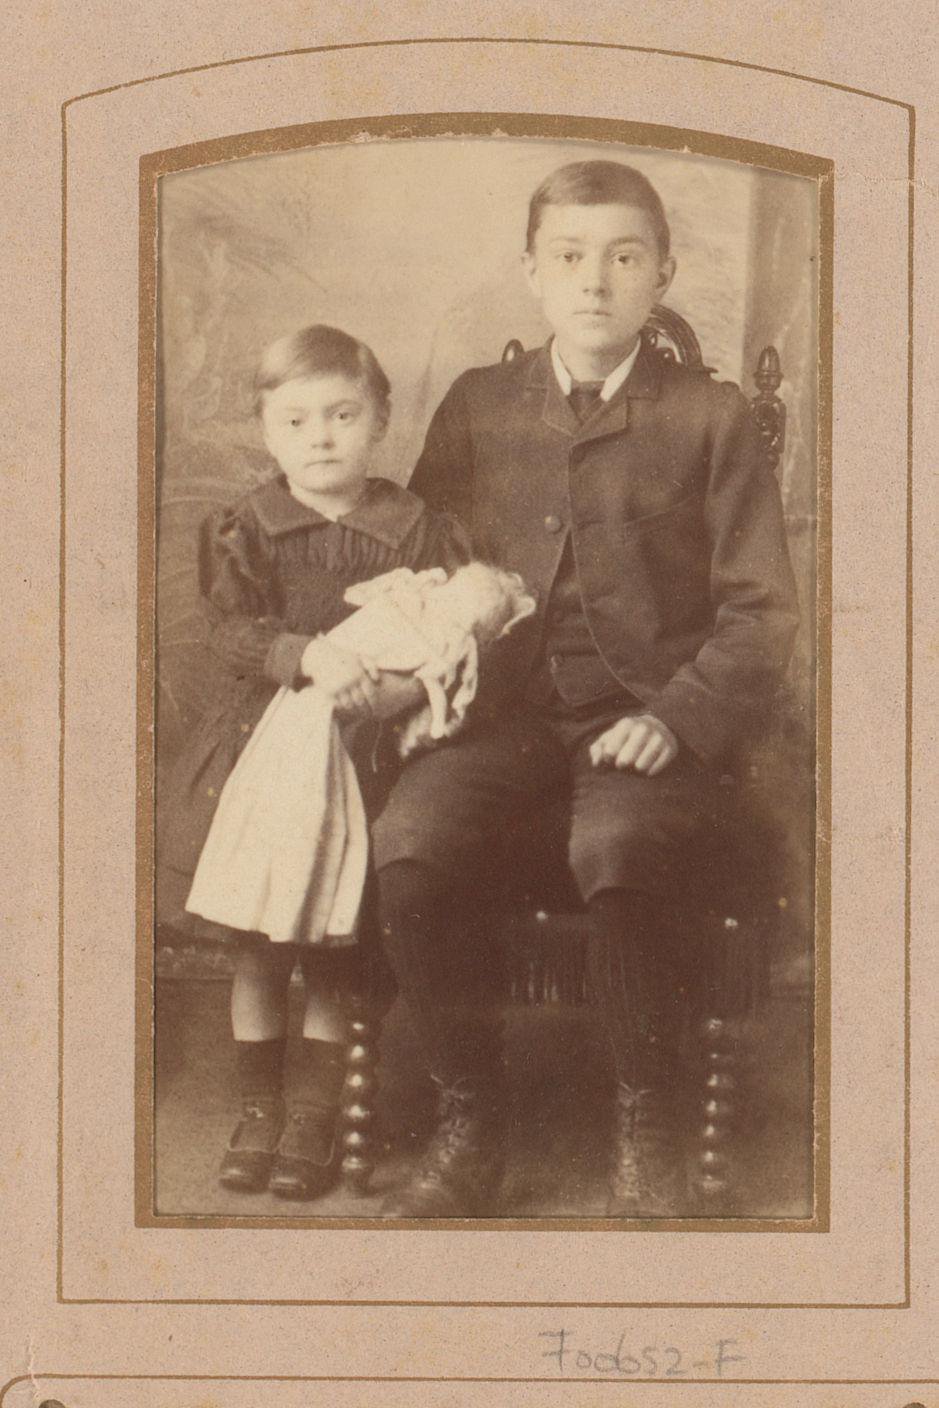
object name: carte de visite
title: Portret van een zittende jongen en een meisje met pop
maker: william bond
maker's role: fotograaf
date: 1882-1900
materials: cardboard, photographic support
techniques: albumen print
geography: norwich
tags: historical persons - bb - woman, boy (child between toddler and youth), historical persons, (playing with) dolls, toddler (female)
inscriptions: inscription: ‘Art/ Photographer/ W. Bond,/ Bank Plain/ and/ New Catton,/ Norwich./ schools, wedding parties/ & every class of outdoor/ work attended to./ copies & enlargements/ can always be had.’